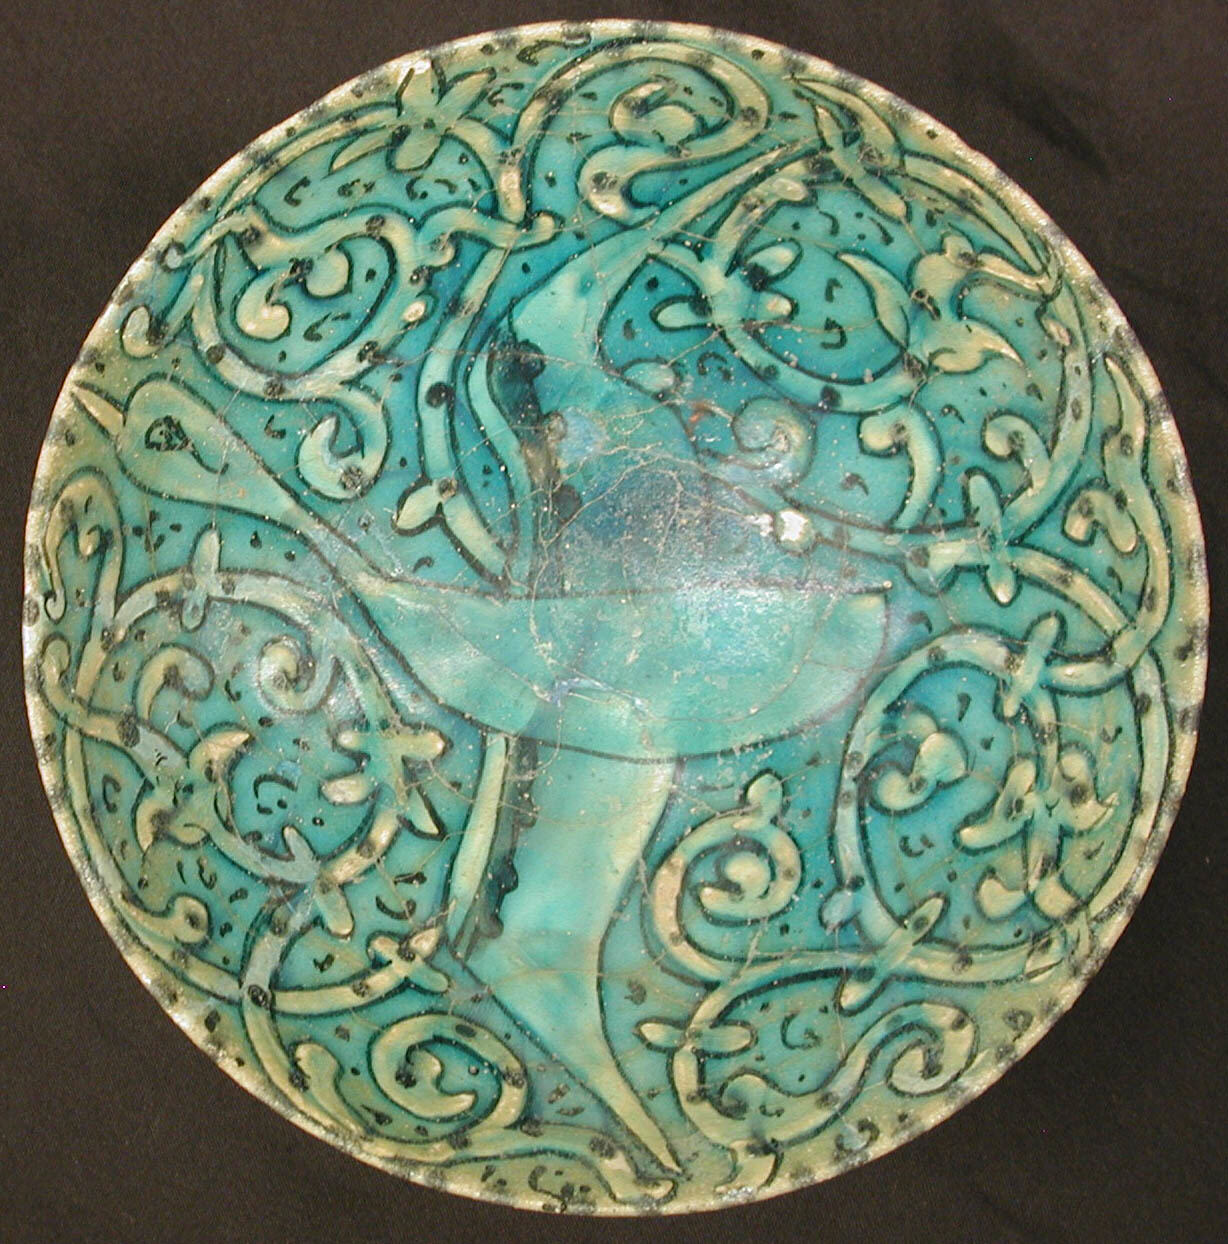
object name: bowl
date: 1301-1333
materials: glaze, stonepaste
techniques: molding, painting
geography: iran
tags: birds